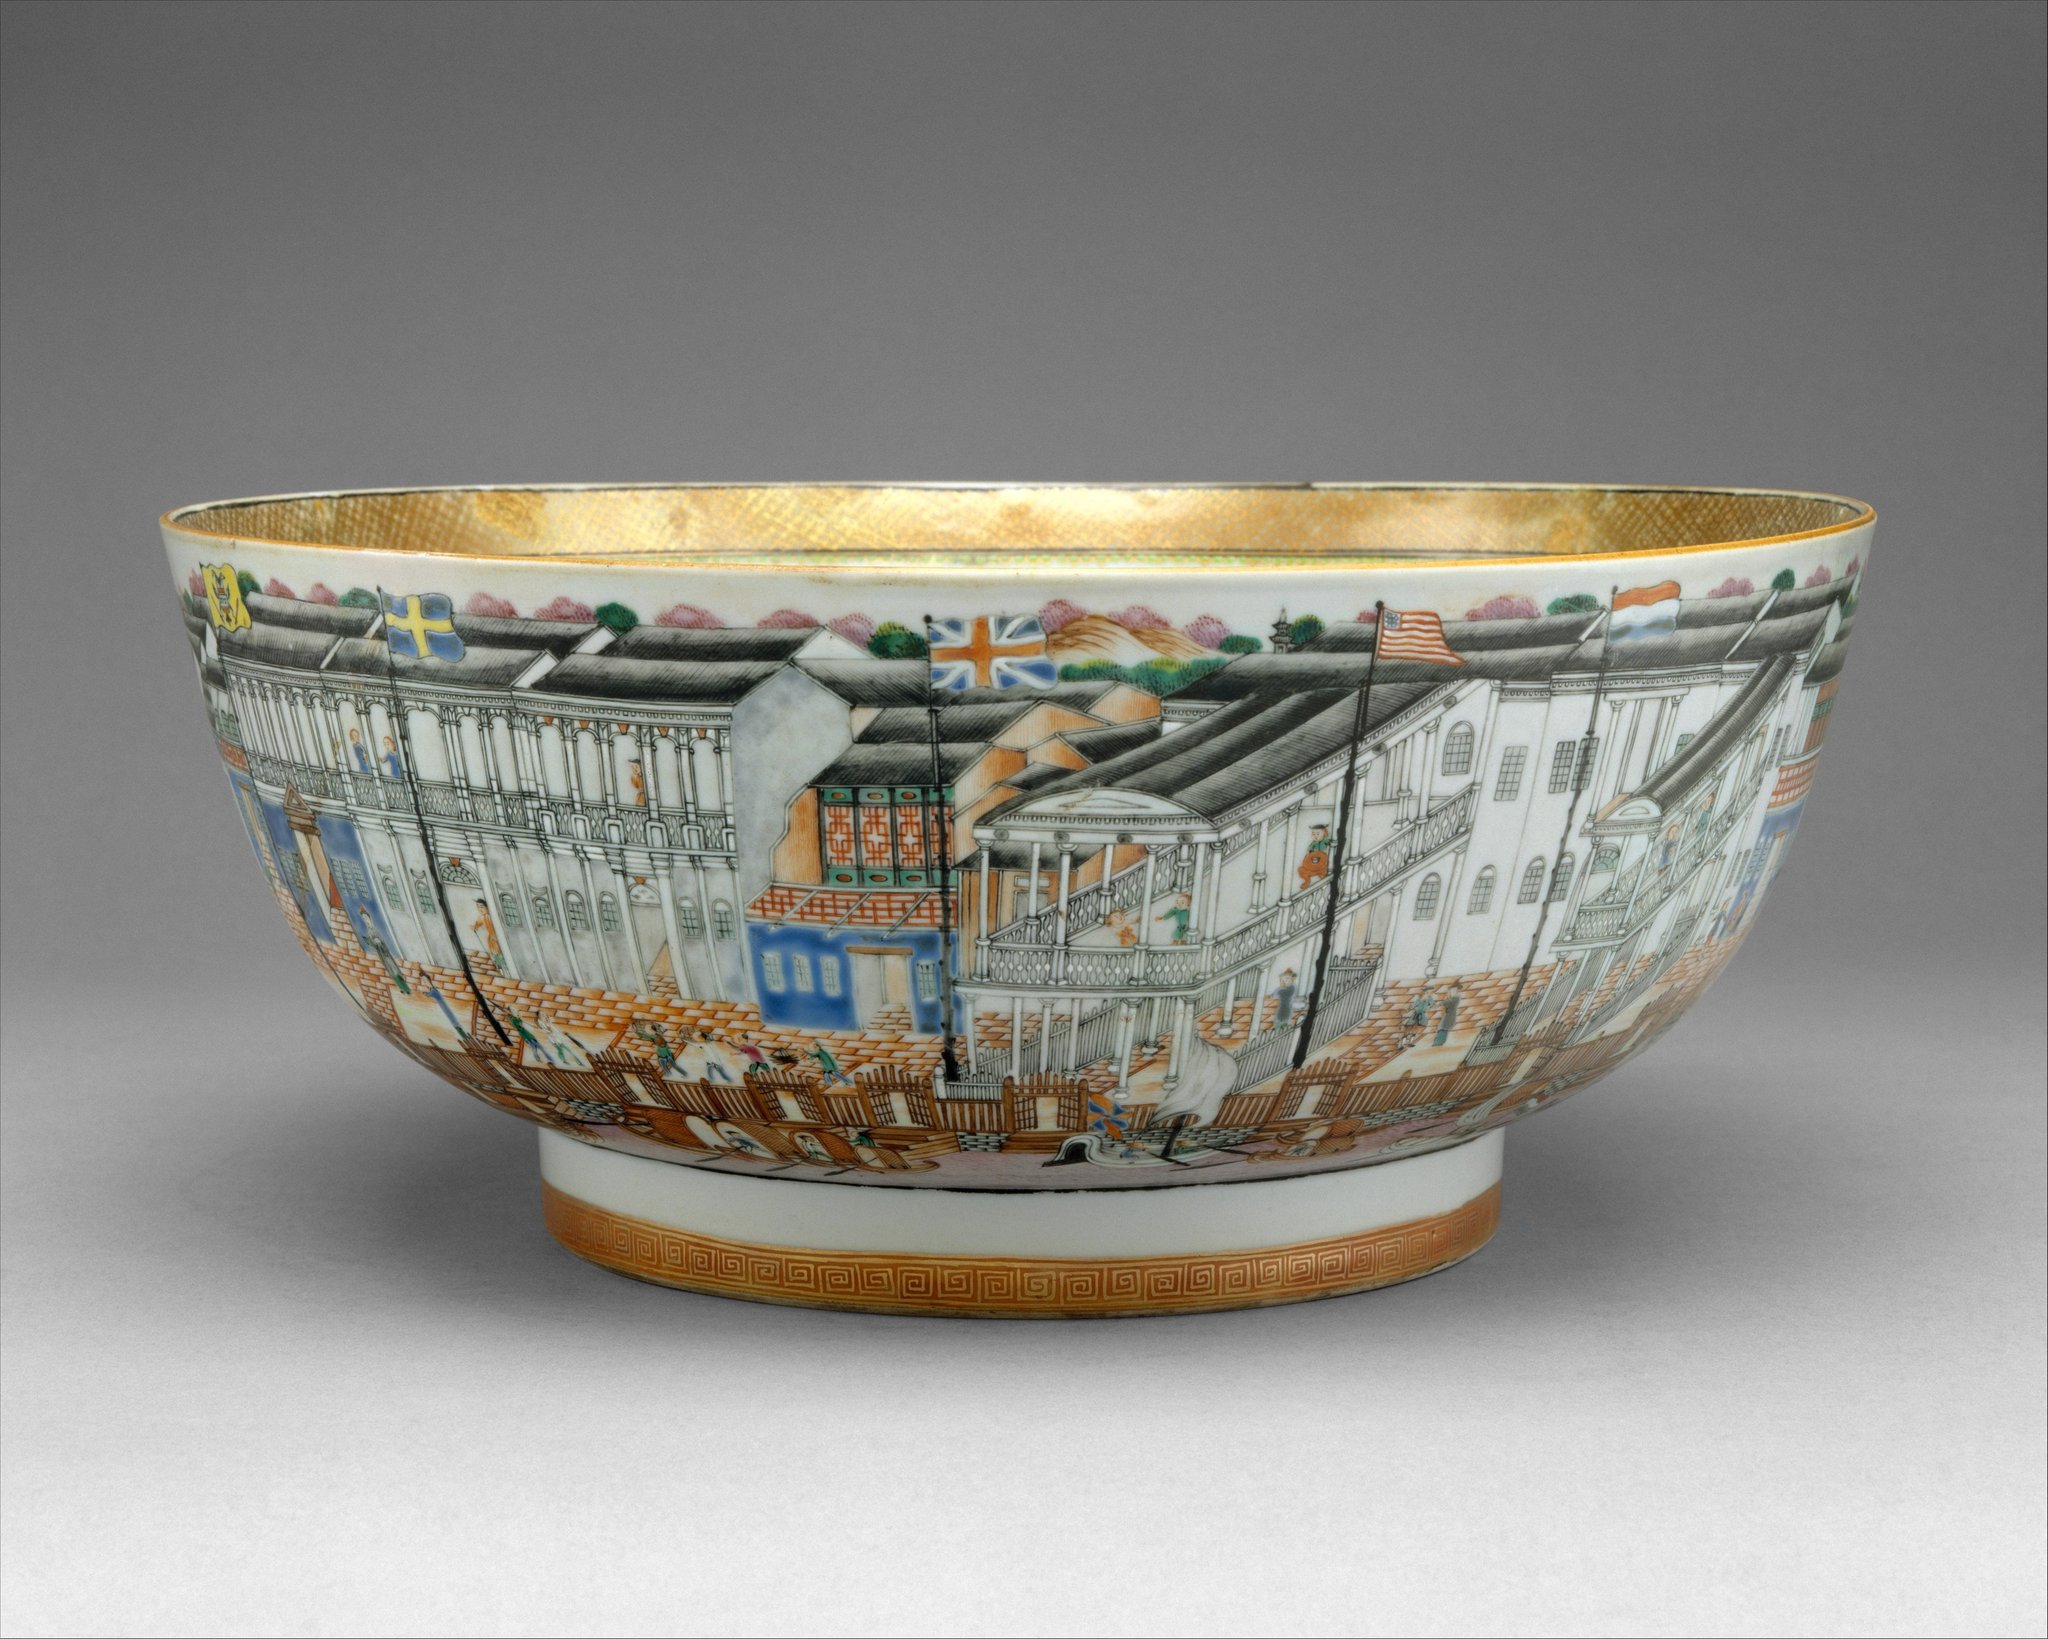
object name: punch bowl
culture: chinese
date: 1785-1800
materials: porcelain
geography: china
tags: factories